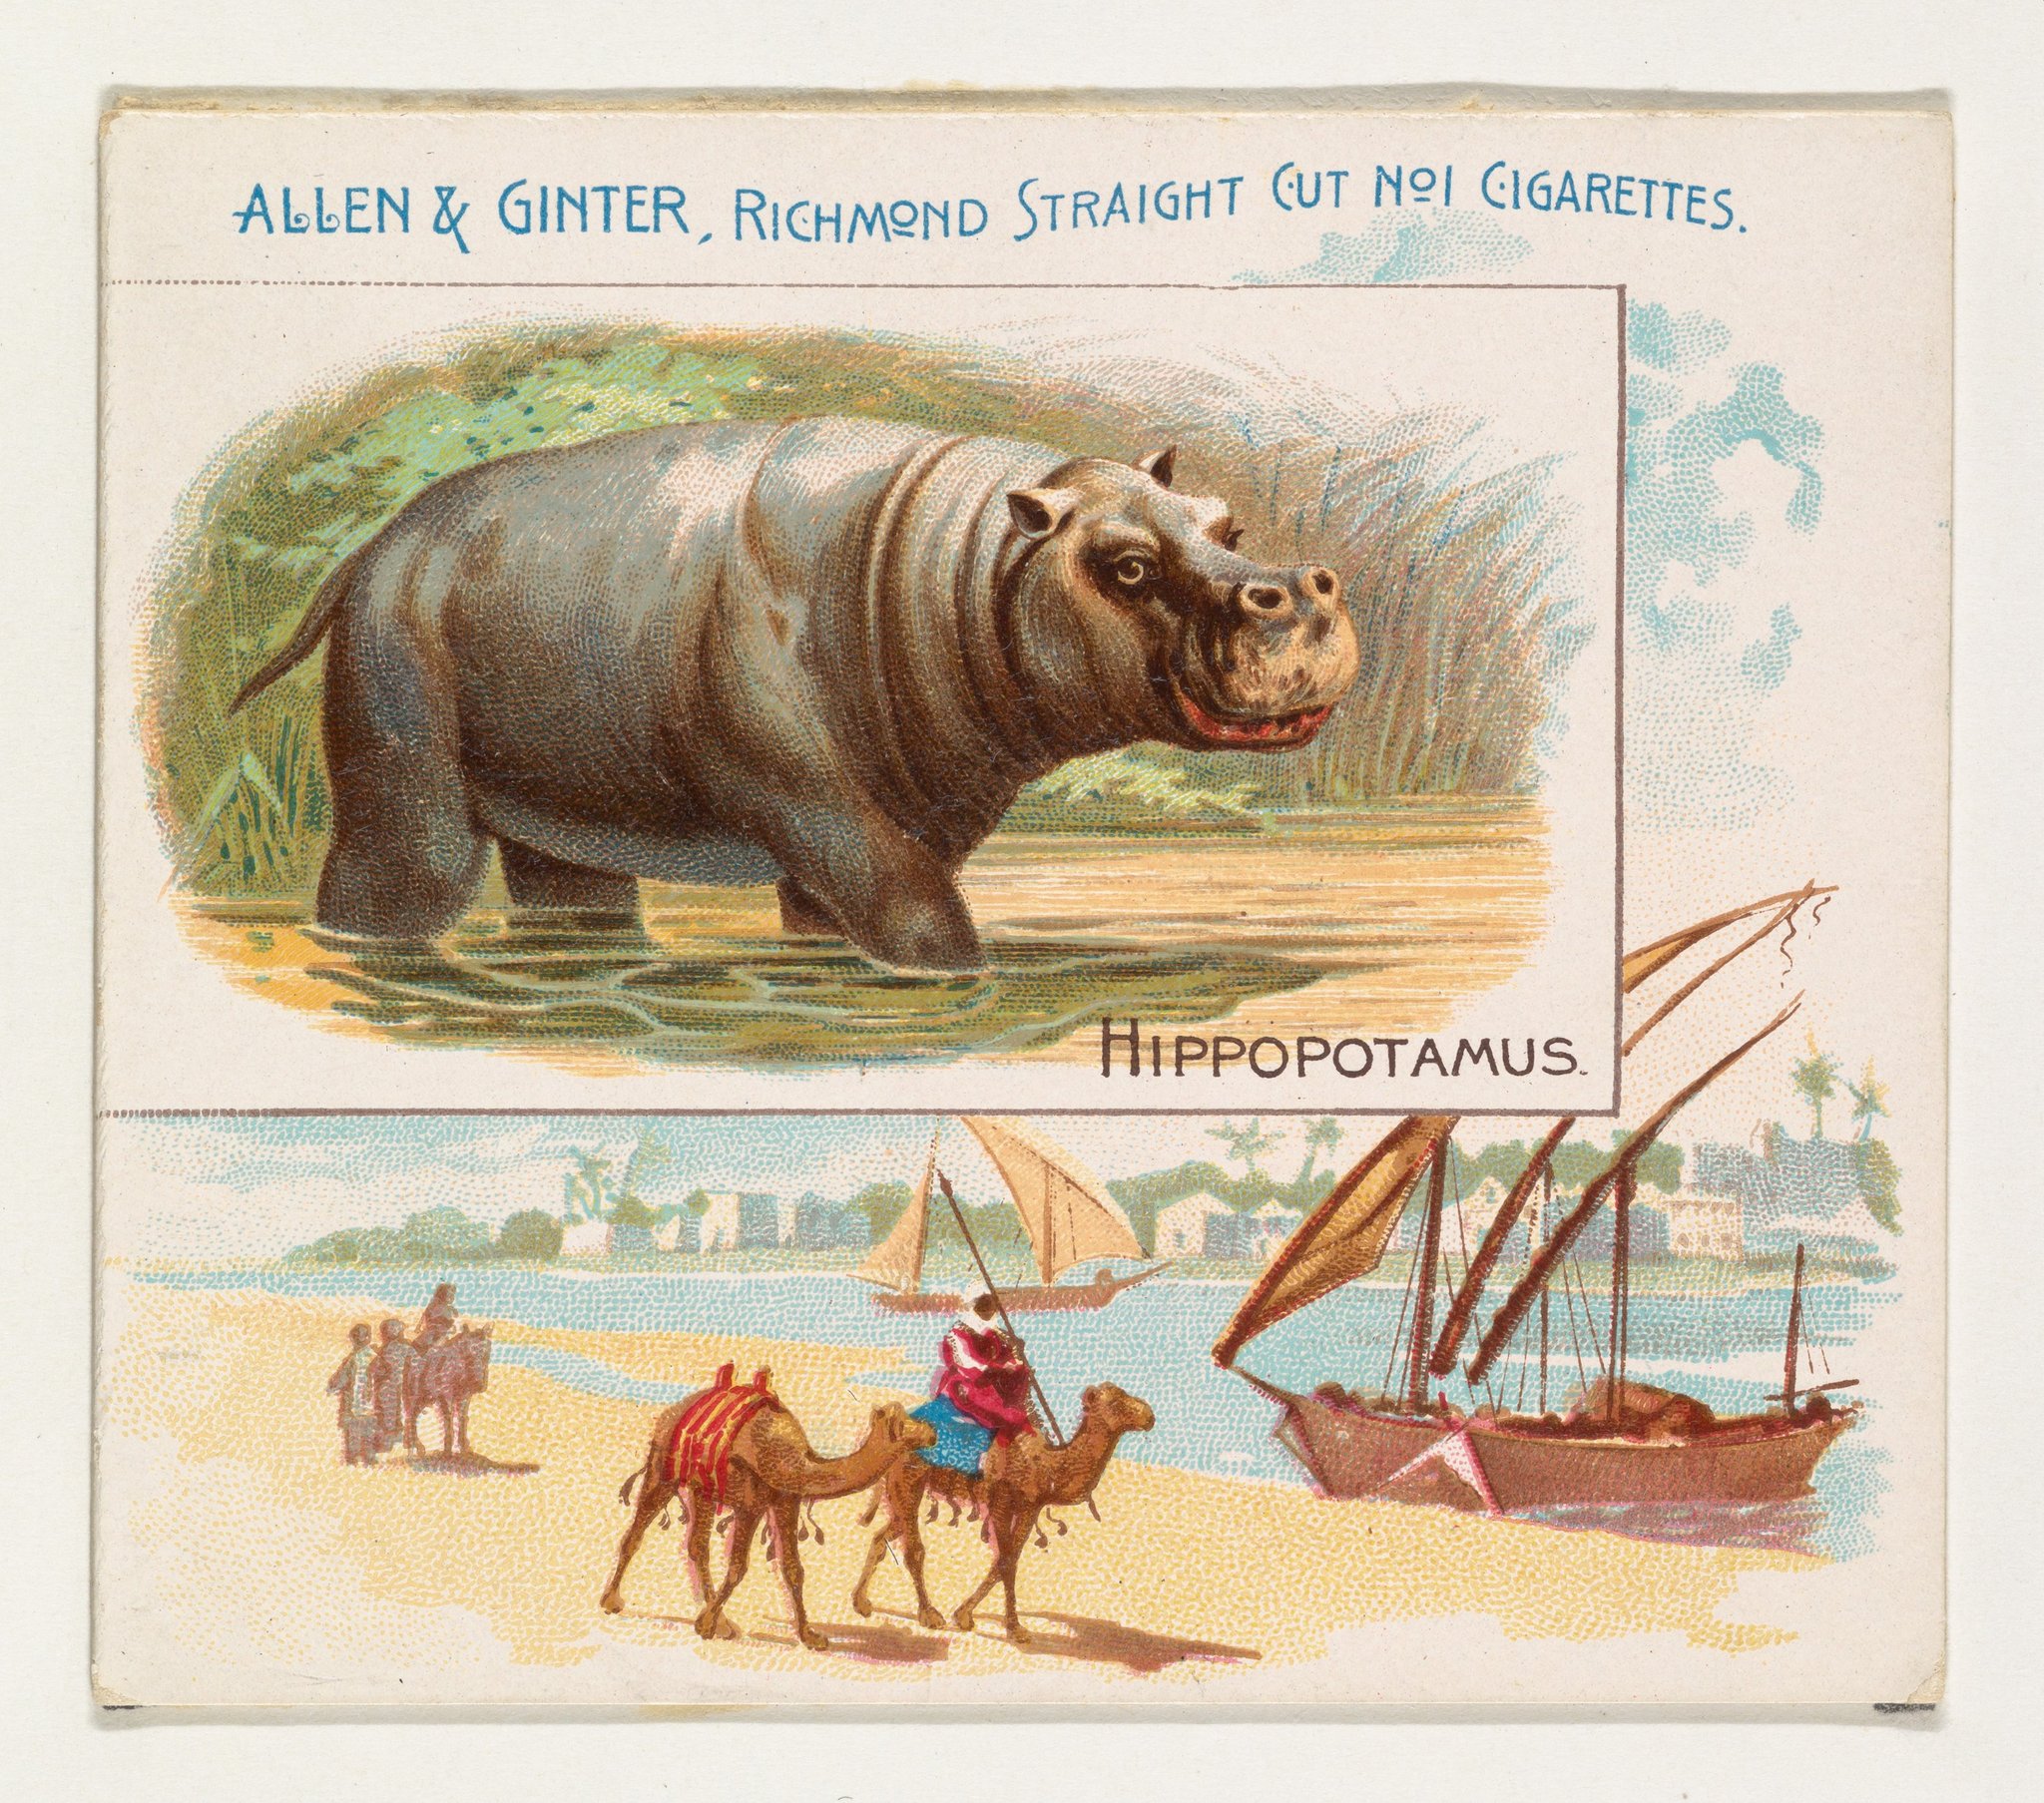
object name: print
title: Hippopotamus, from Quadrupeds series (N41) for Allen & Ginter Cigarettes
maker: allen & ginter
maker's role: publisher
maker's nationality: american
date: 1890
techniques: color lithograph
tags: hippos